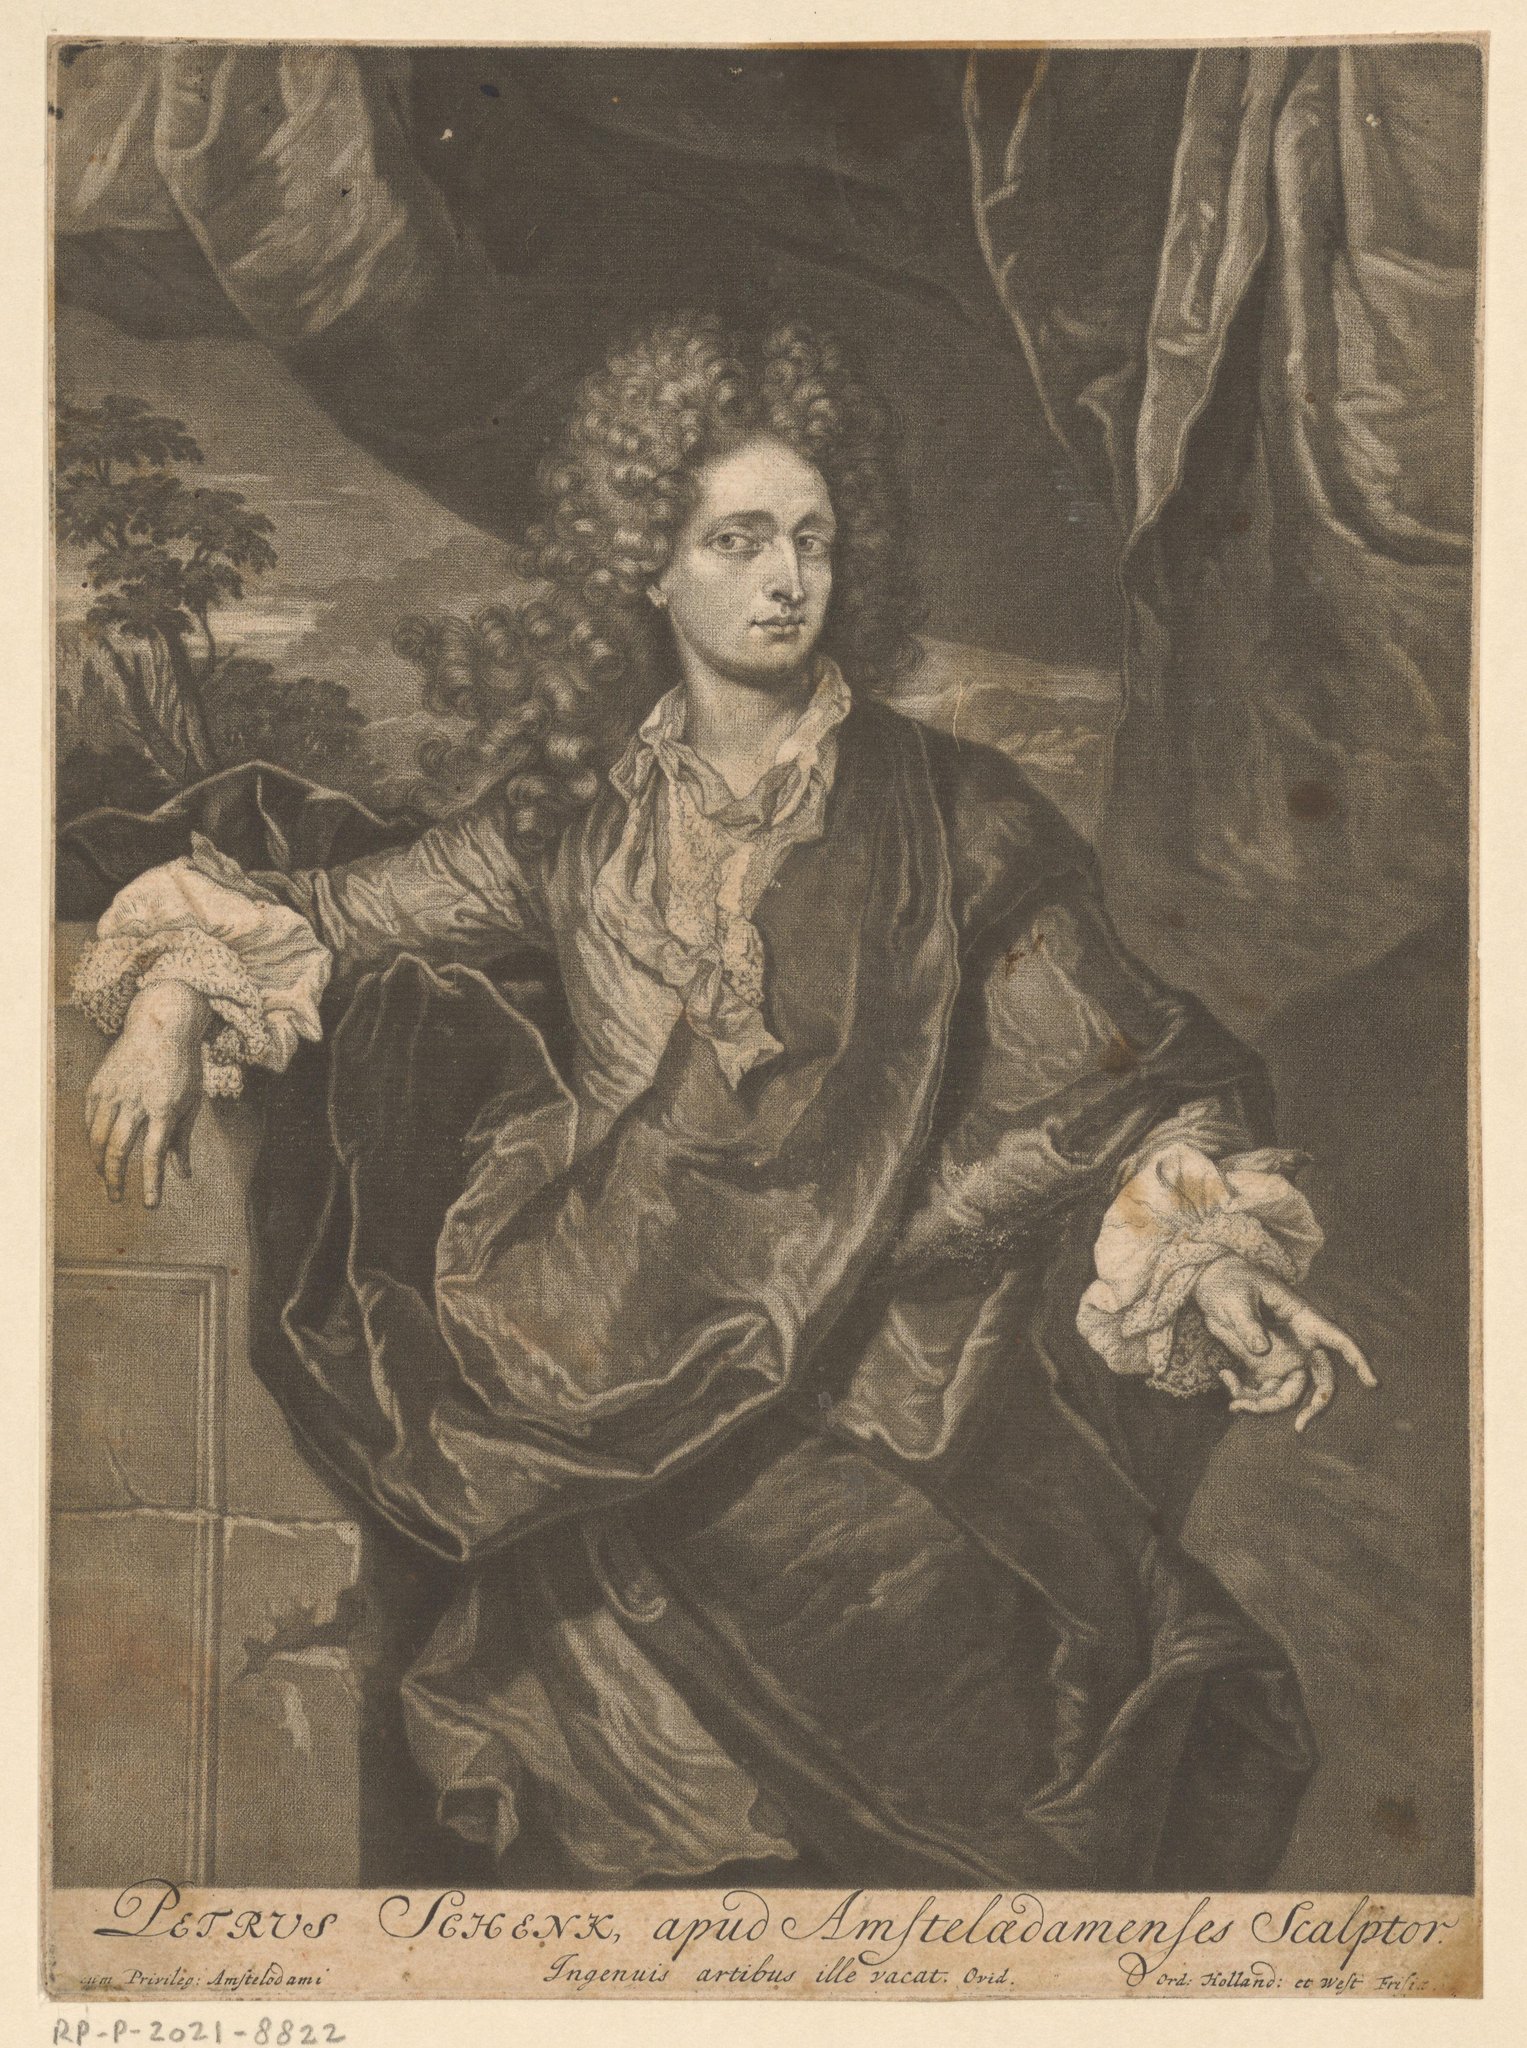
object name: print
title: Zelfportret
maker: pieter schenk (i)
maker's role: print maker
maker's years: 1660-1711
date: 1675-1711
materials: paper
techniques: engraving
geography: amsterdam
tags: print maker, pieter schenk (i), historical persons, portrait, self-portrait of painter